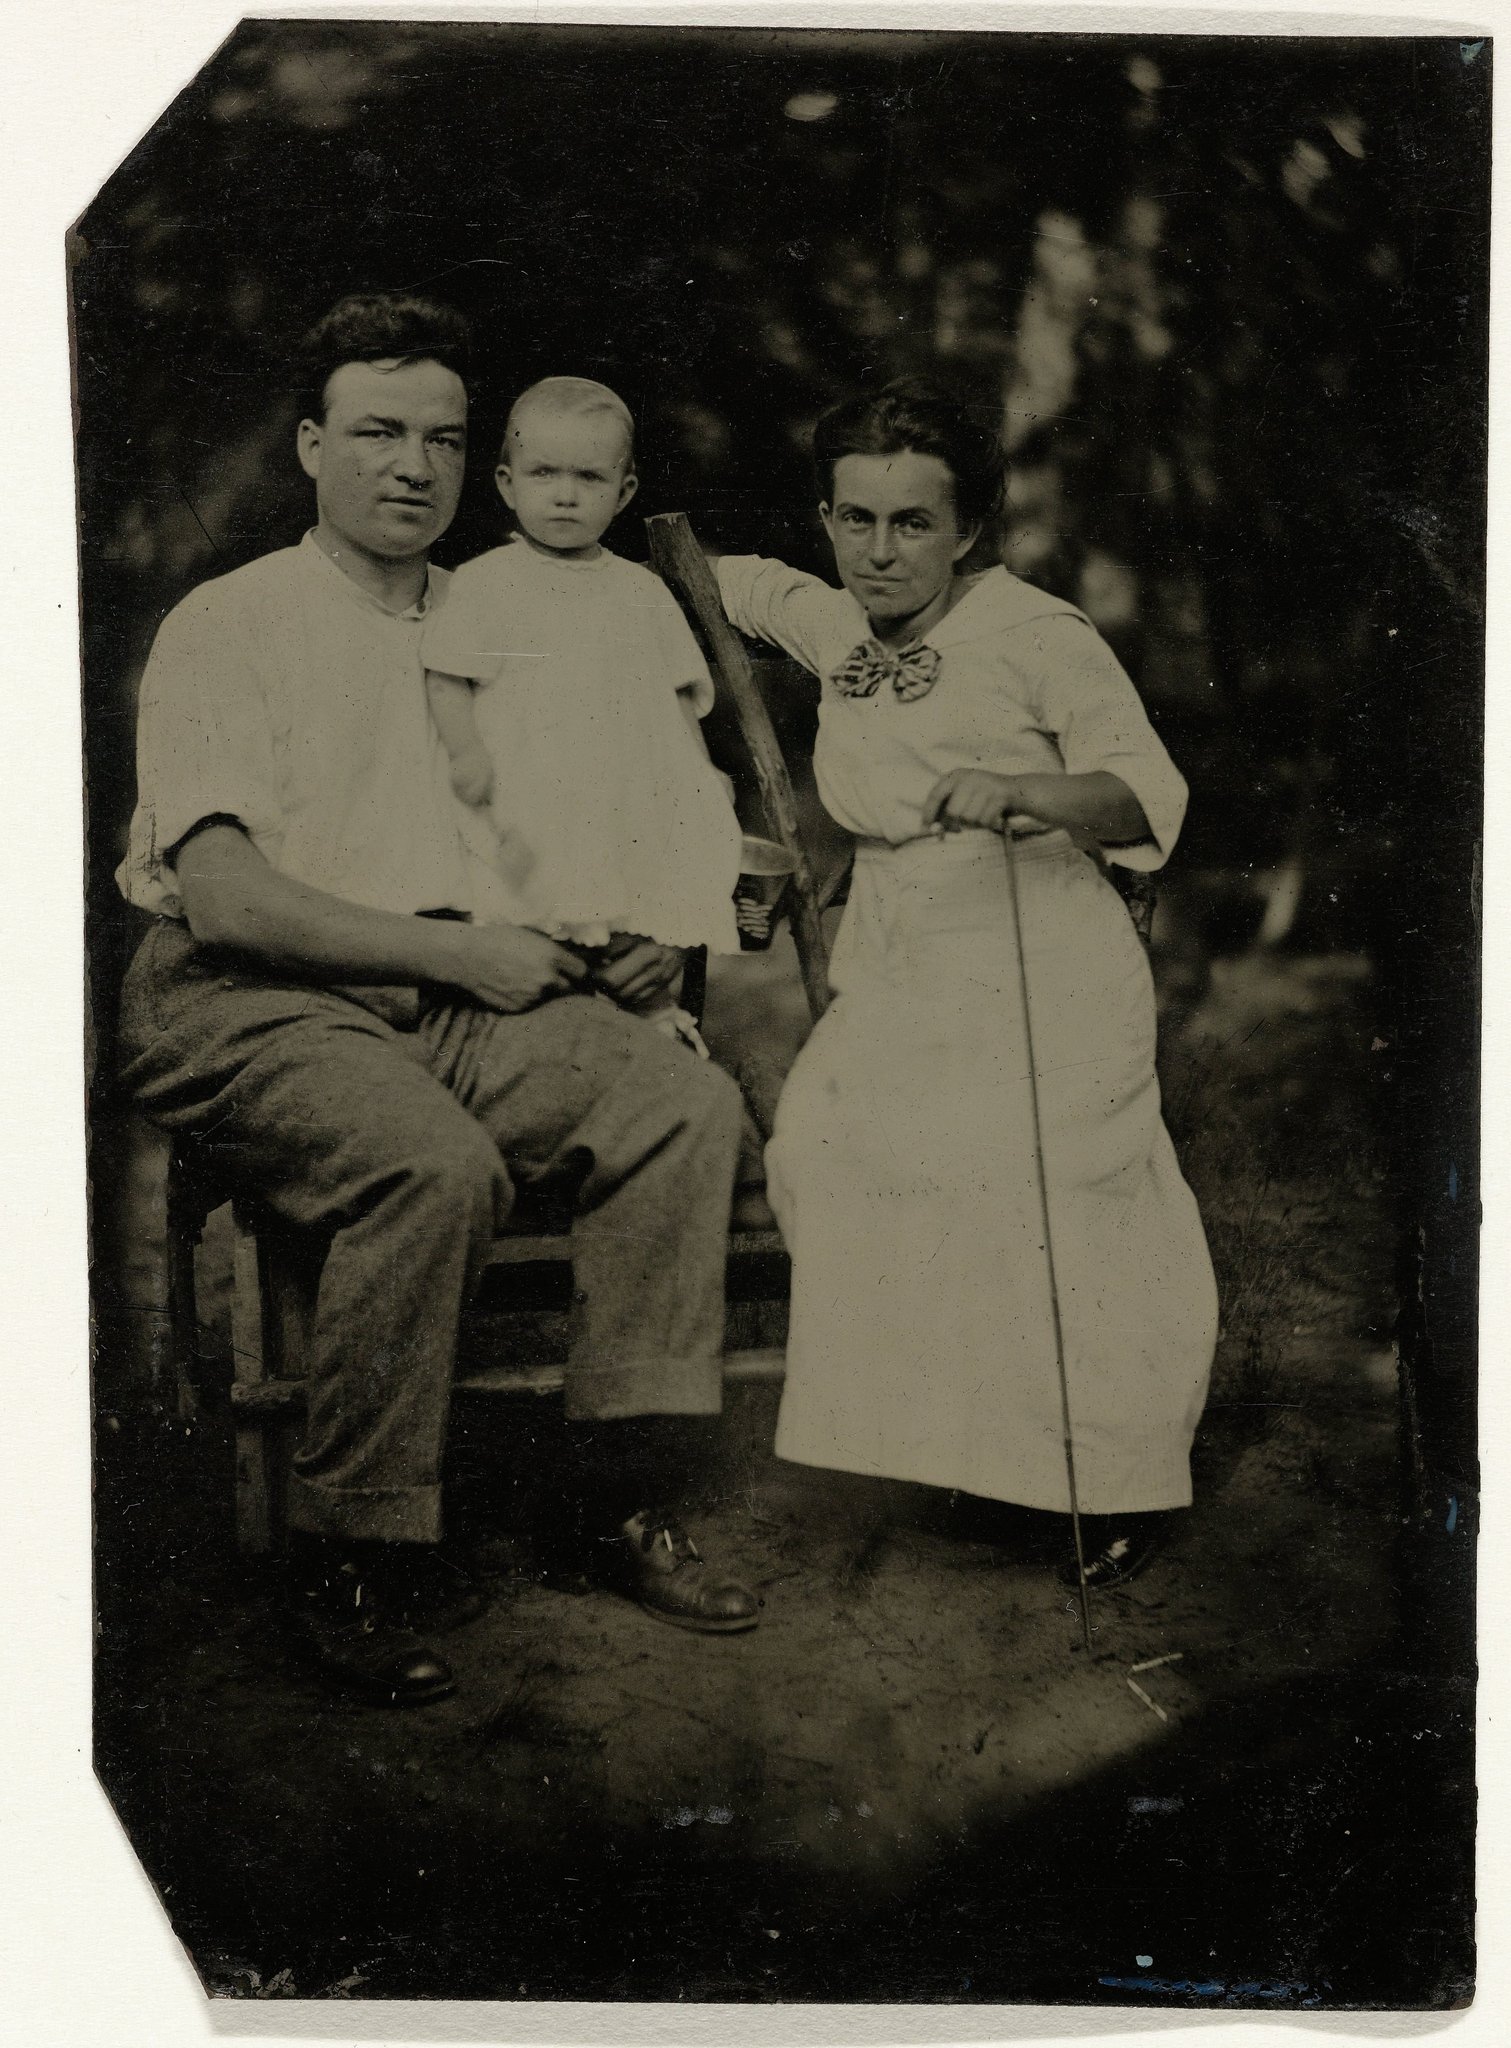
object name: photograph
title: Portret van een man, vrouw en kind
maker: Anonymous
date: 1870-1910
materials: metal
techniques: ferrotyping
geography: north and central america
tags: family, relationship, descent, family life at home